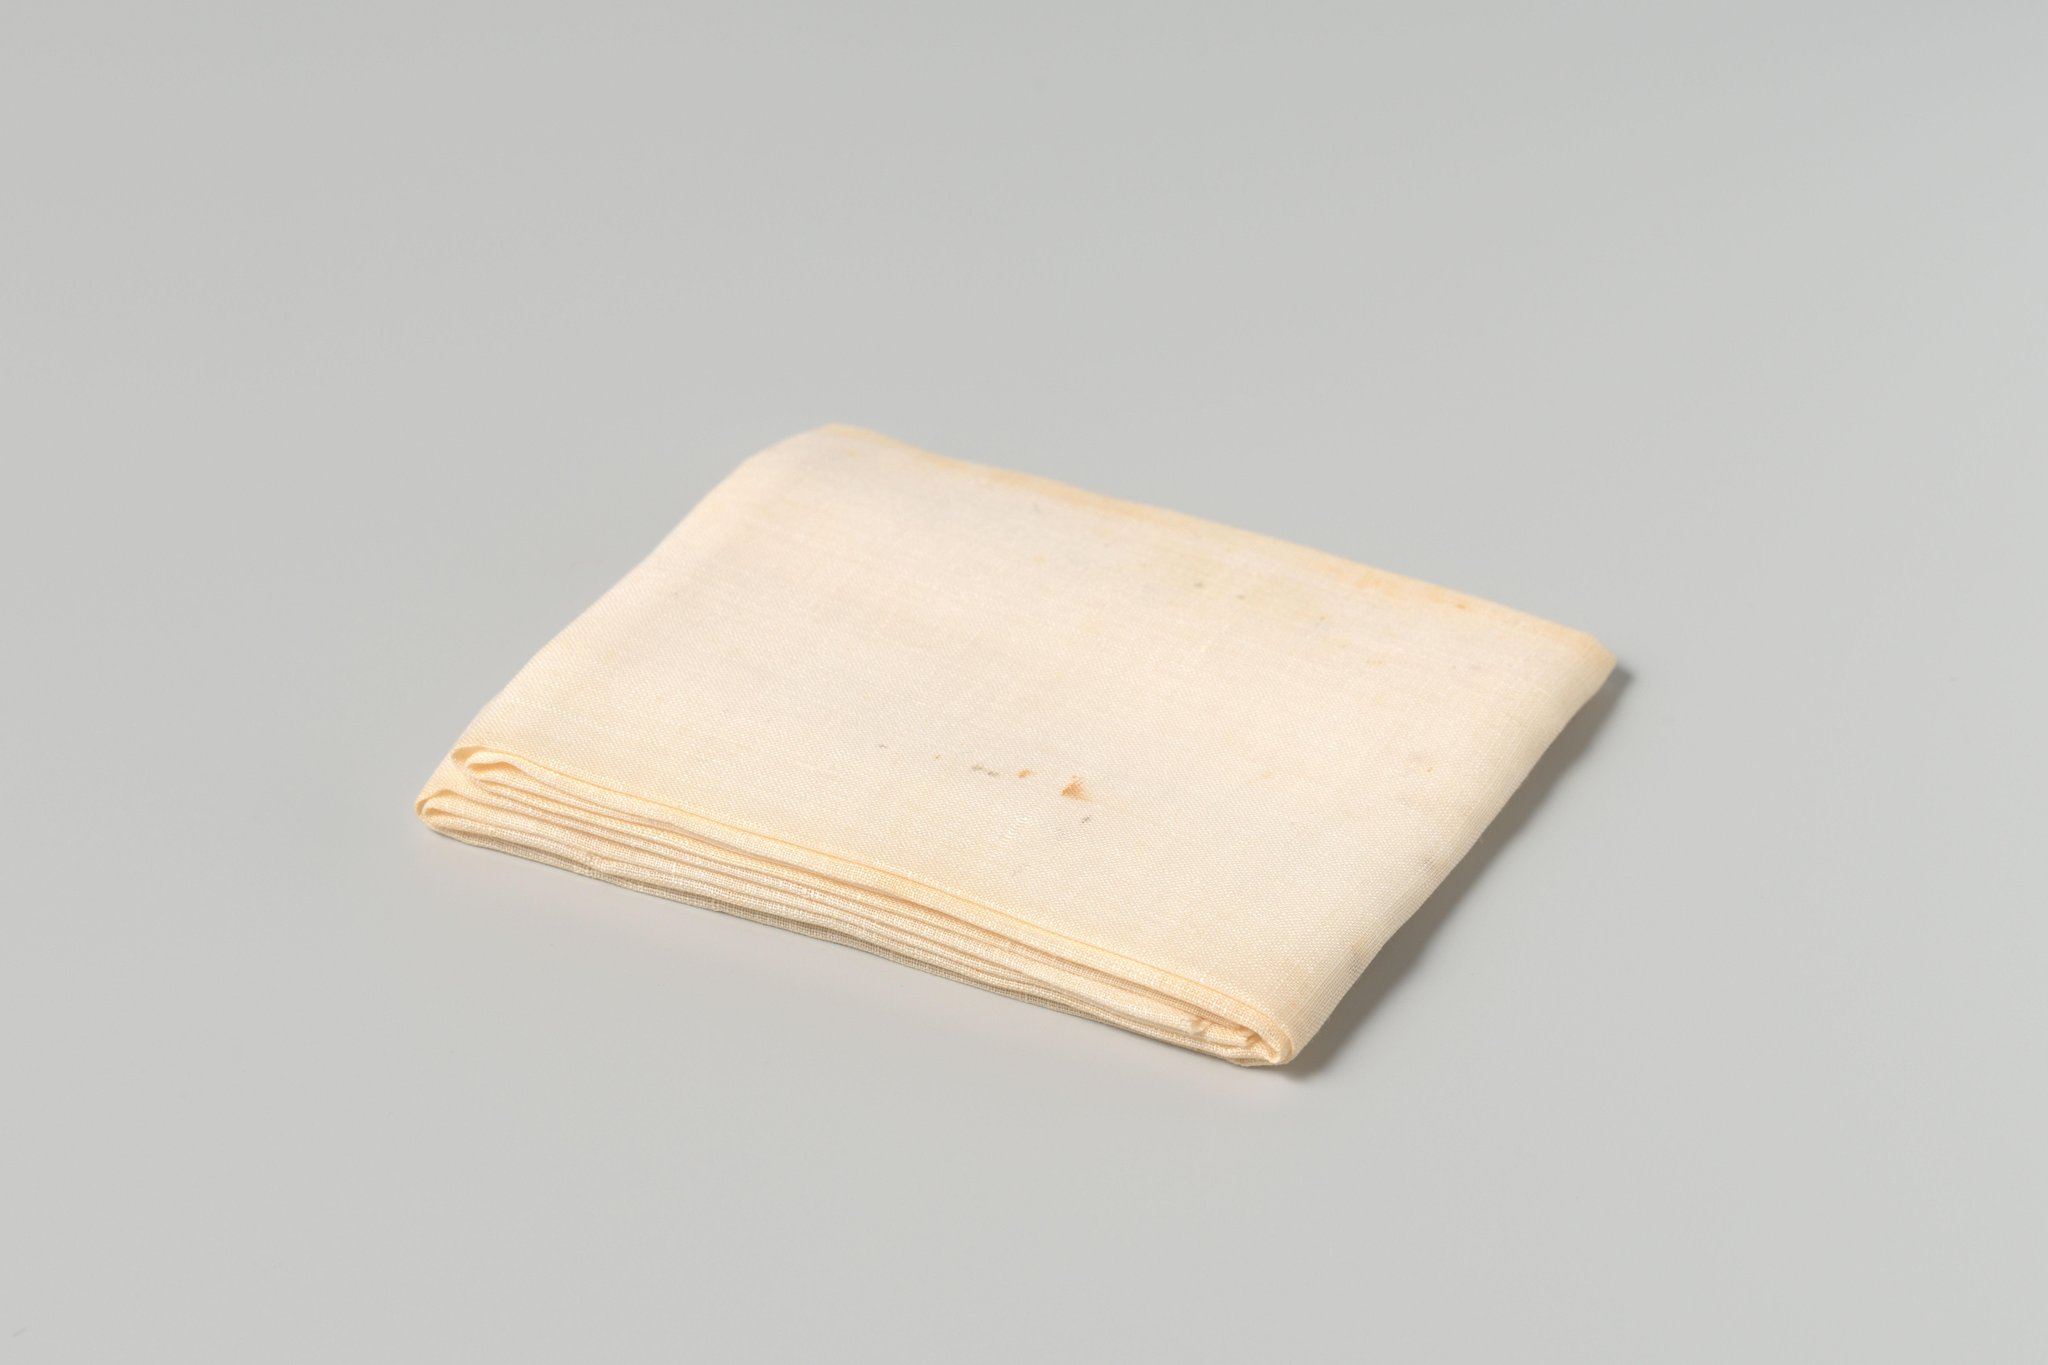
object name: beddenlaken, laken object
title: Laken of lap, omgezoomd.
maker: Anonymous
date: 1675-1899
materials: linen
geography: netherlands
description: Lap, op het formaat van een laken, van fijn linnen, omgezoomd.